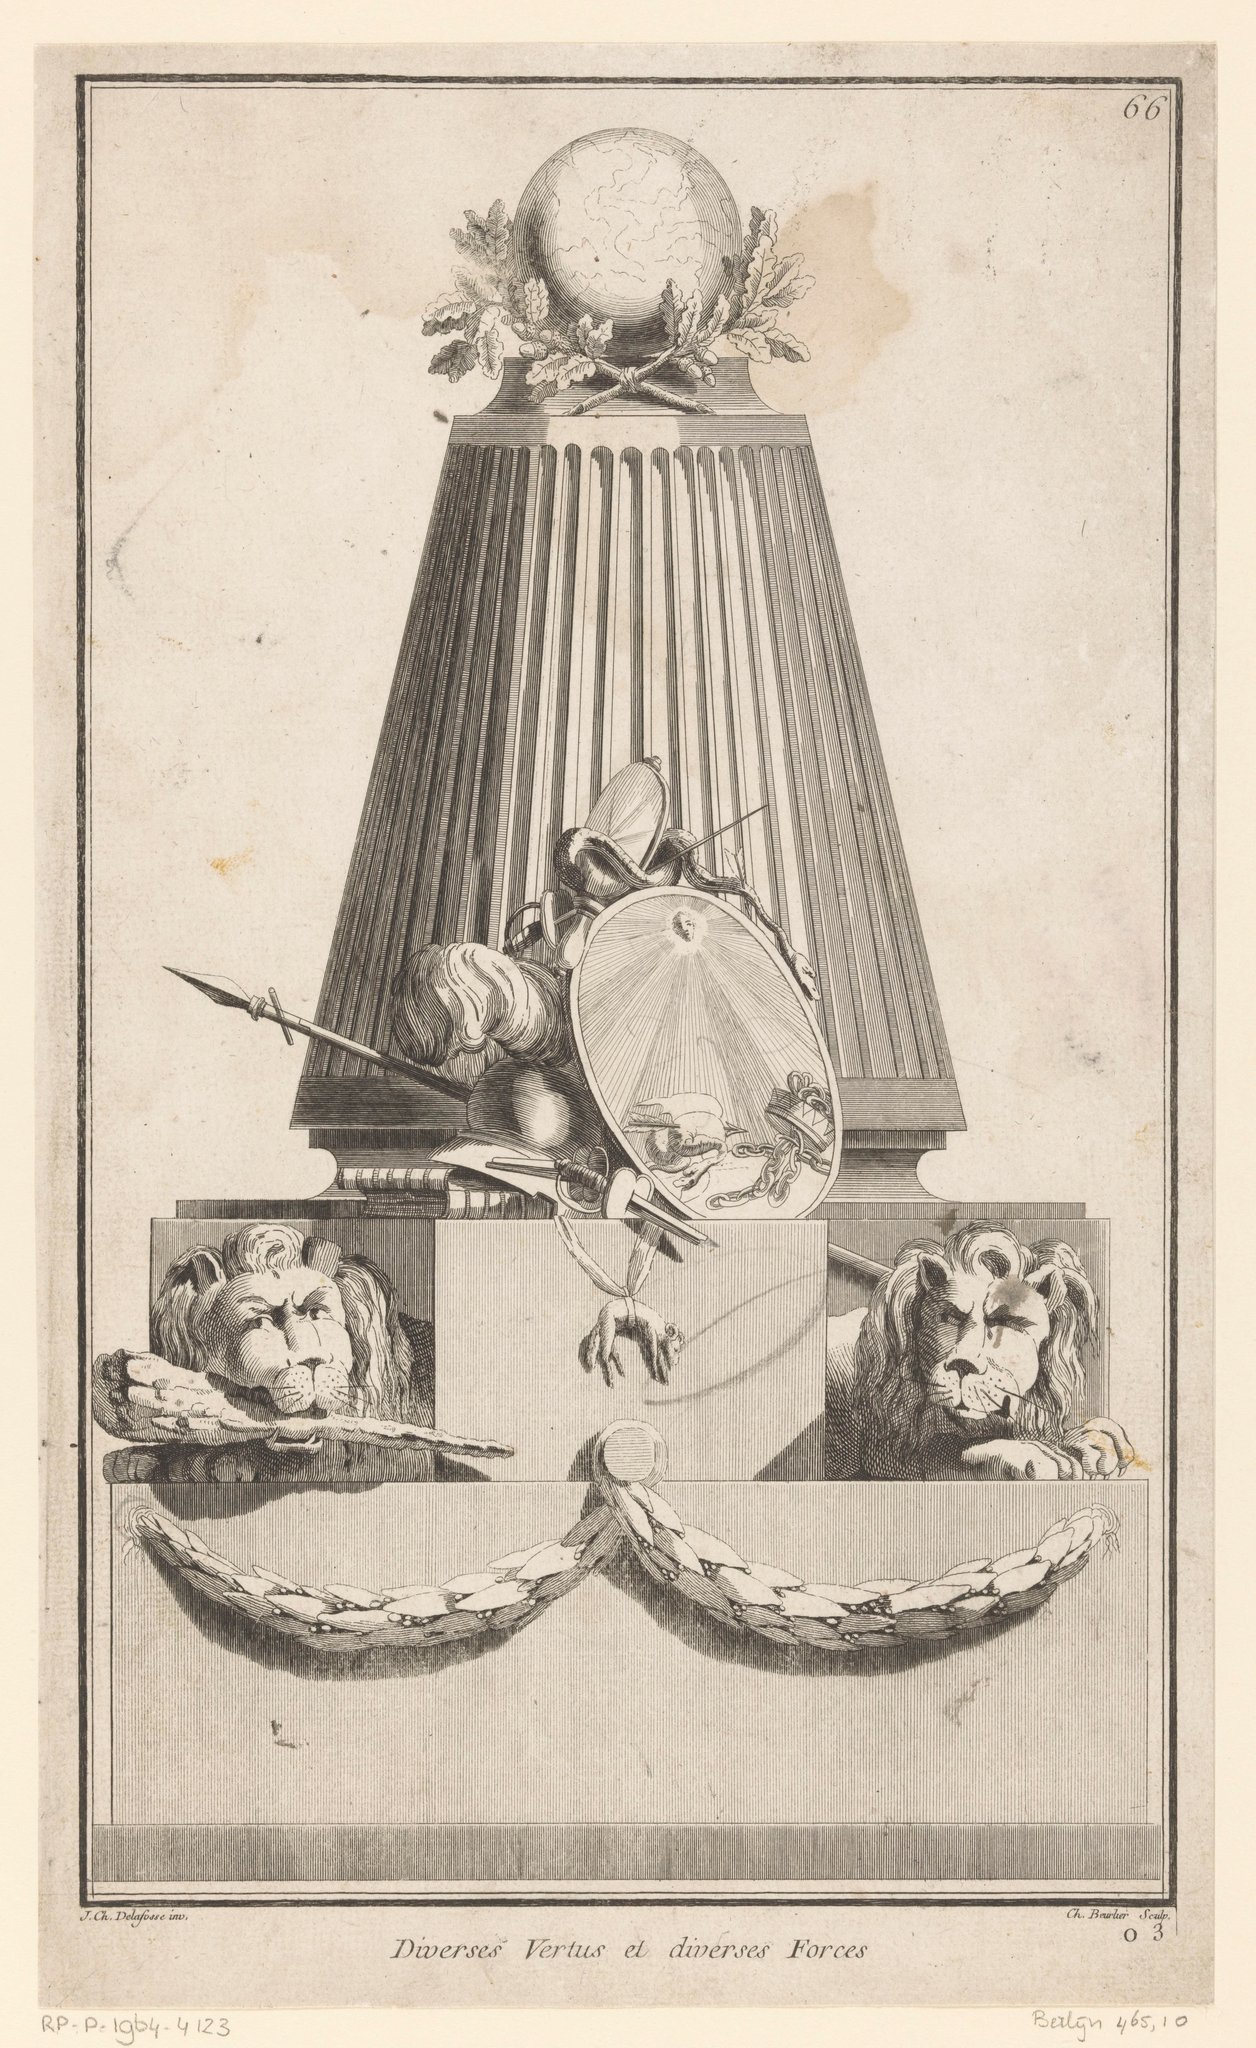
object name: print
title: Deugden en krachten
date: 1768-1771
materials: paper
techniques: engraving, etching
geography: paris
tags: 'sapientia' and the seven virtues, i.e. the three theological and the four cardinal virtues, monument, statue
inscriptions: collector's mark: Lugt 2228, collector's mark: Lugt 2760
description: Een monument met twee leeuwen en een driehoekig element met een globe en eikenbladeren. In het midden de ketting van het gulden vlies, boeken, een helm, wapens en een schild met een draak en een kroon met kettingen. Prentnummer 66.